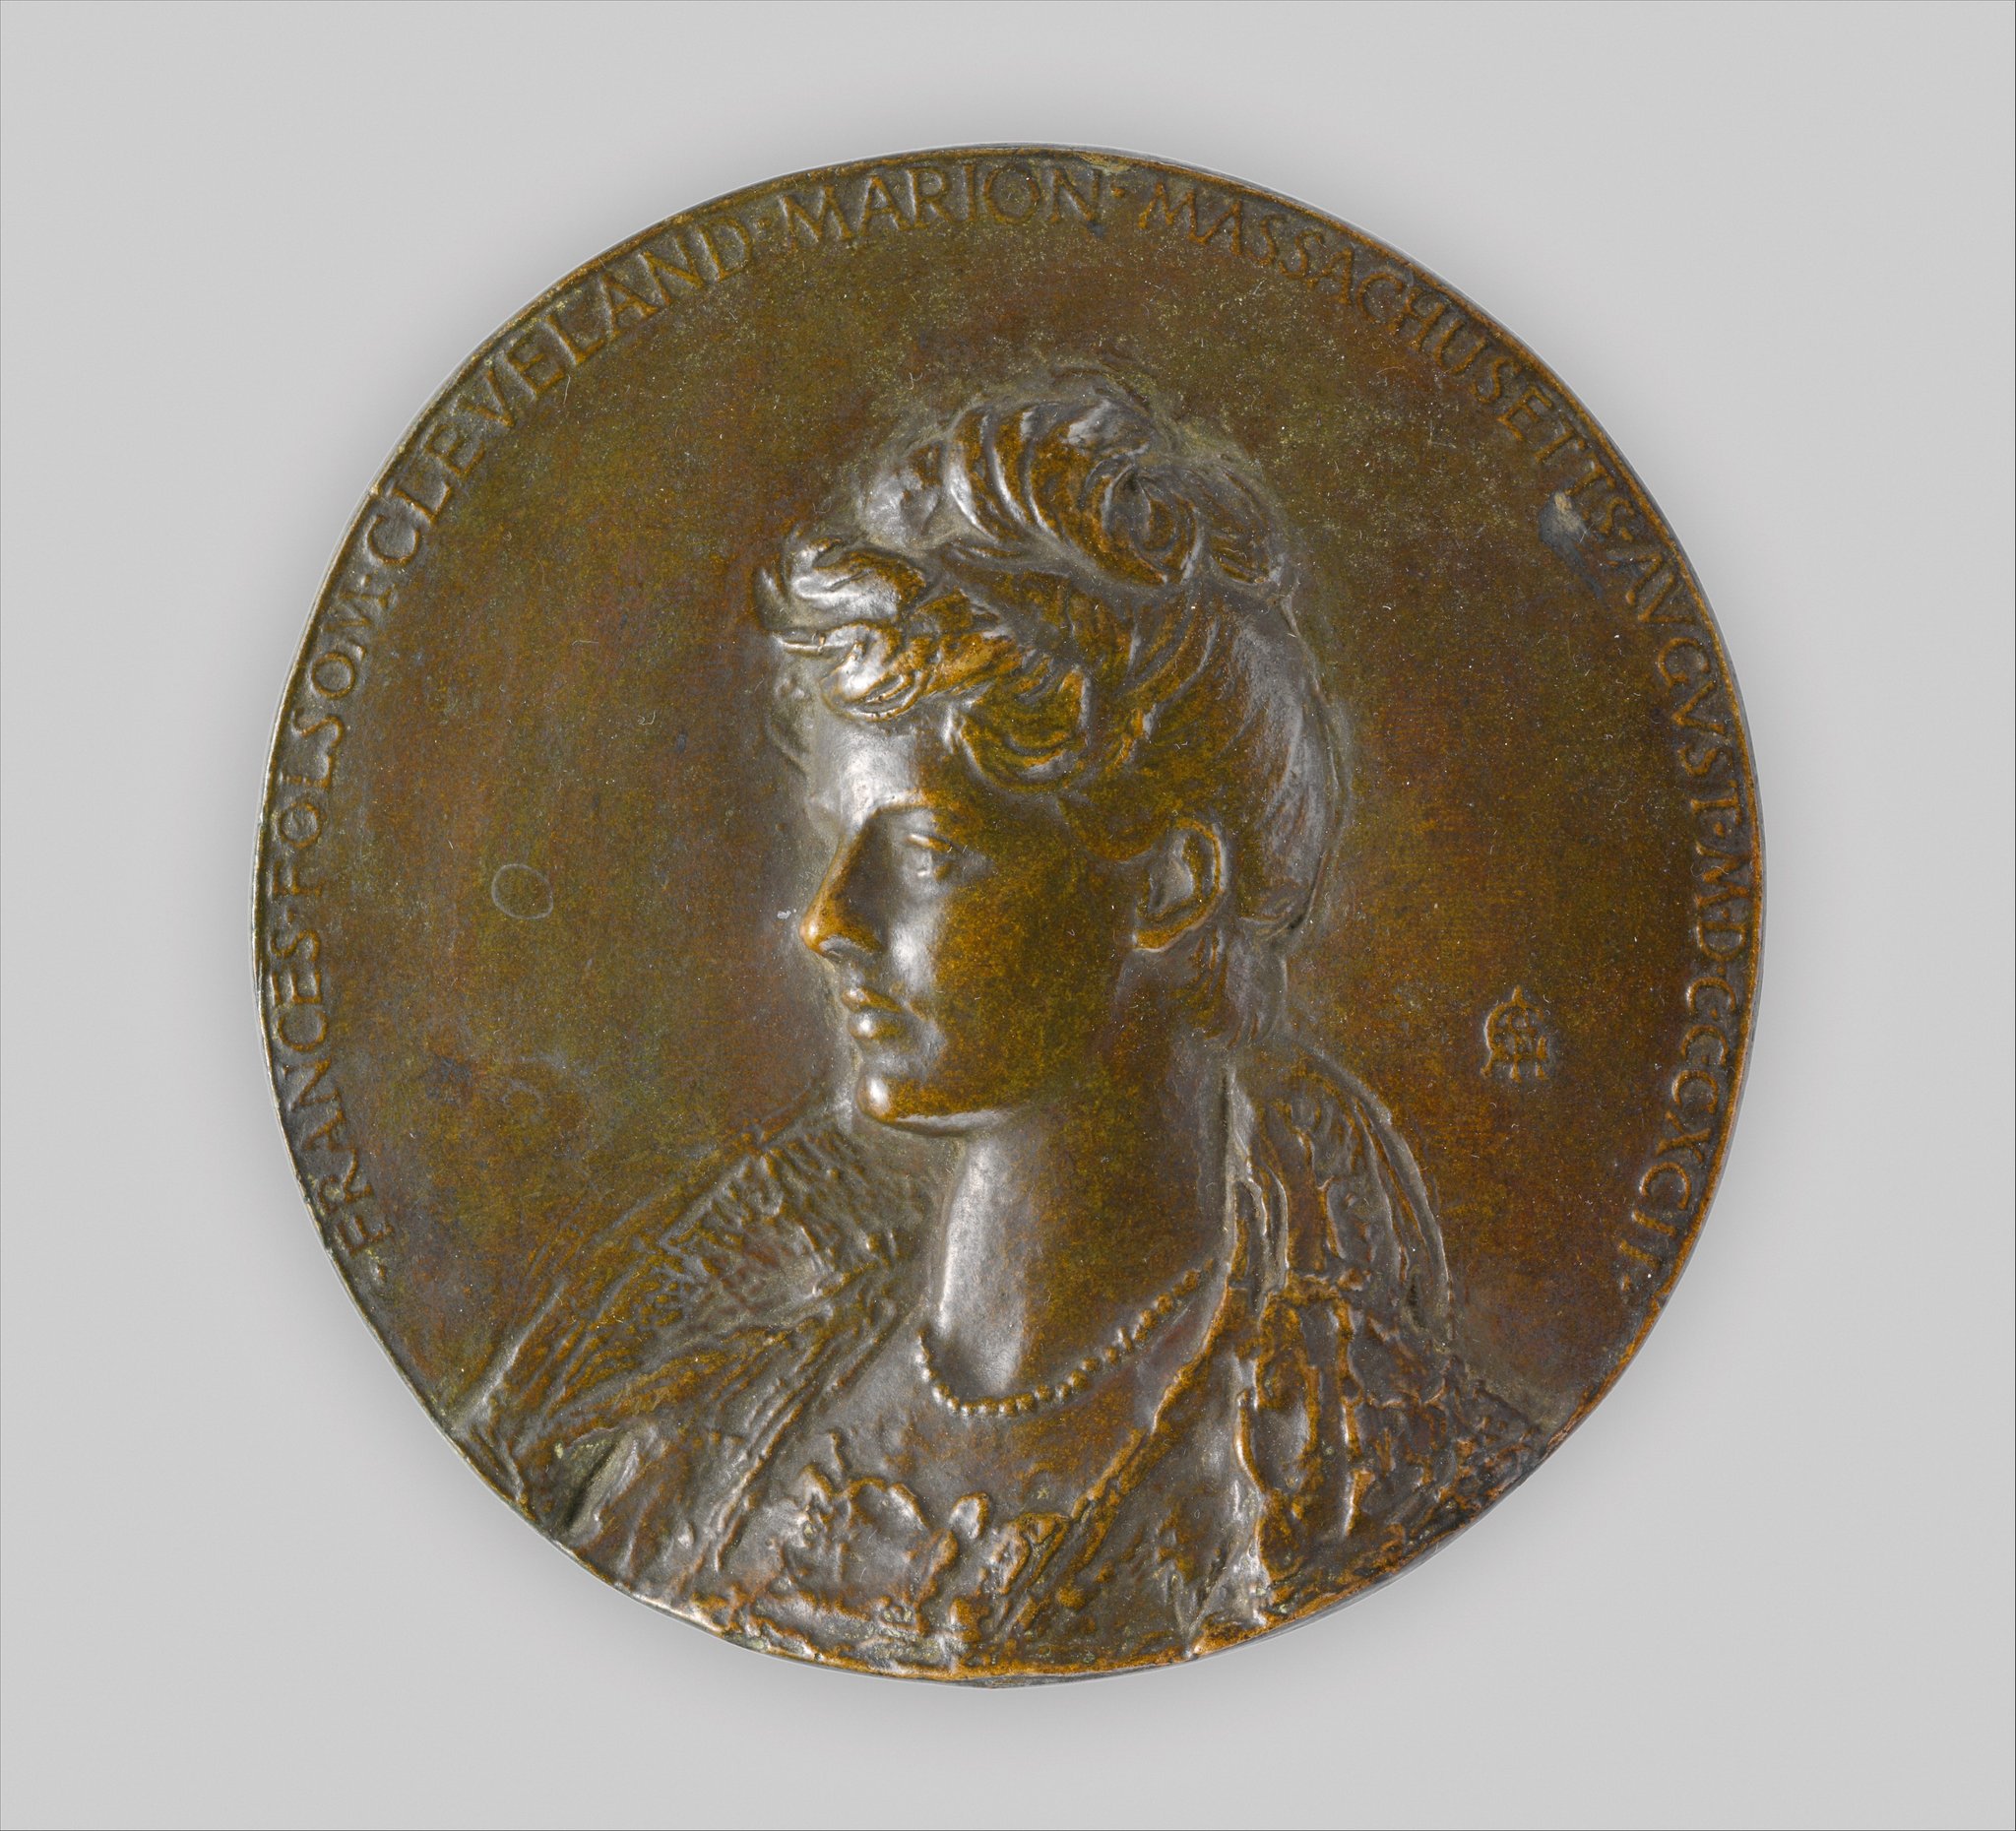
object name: medal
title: Frances Folsom Cleveland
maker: augustus saint-gaudens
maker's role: artist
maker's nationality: american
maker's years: 1848-1907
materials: bronze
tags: portraits,profiles,women